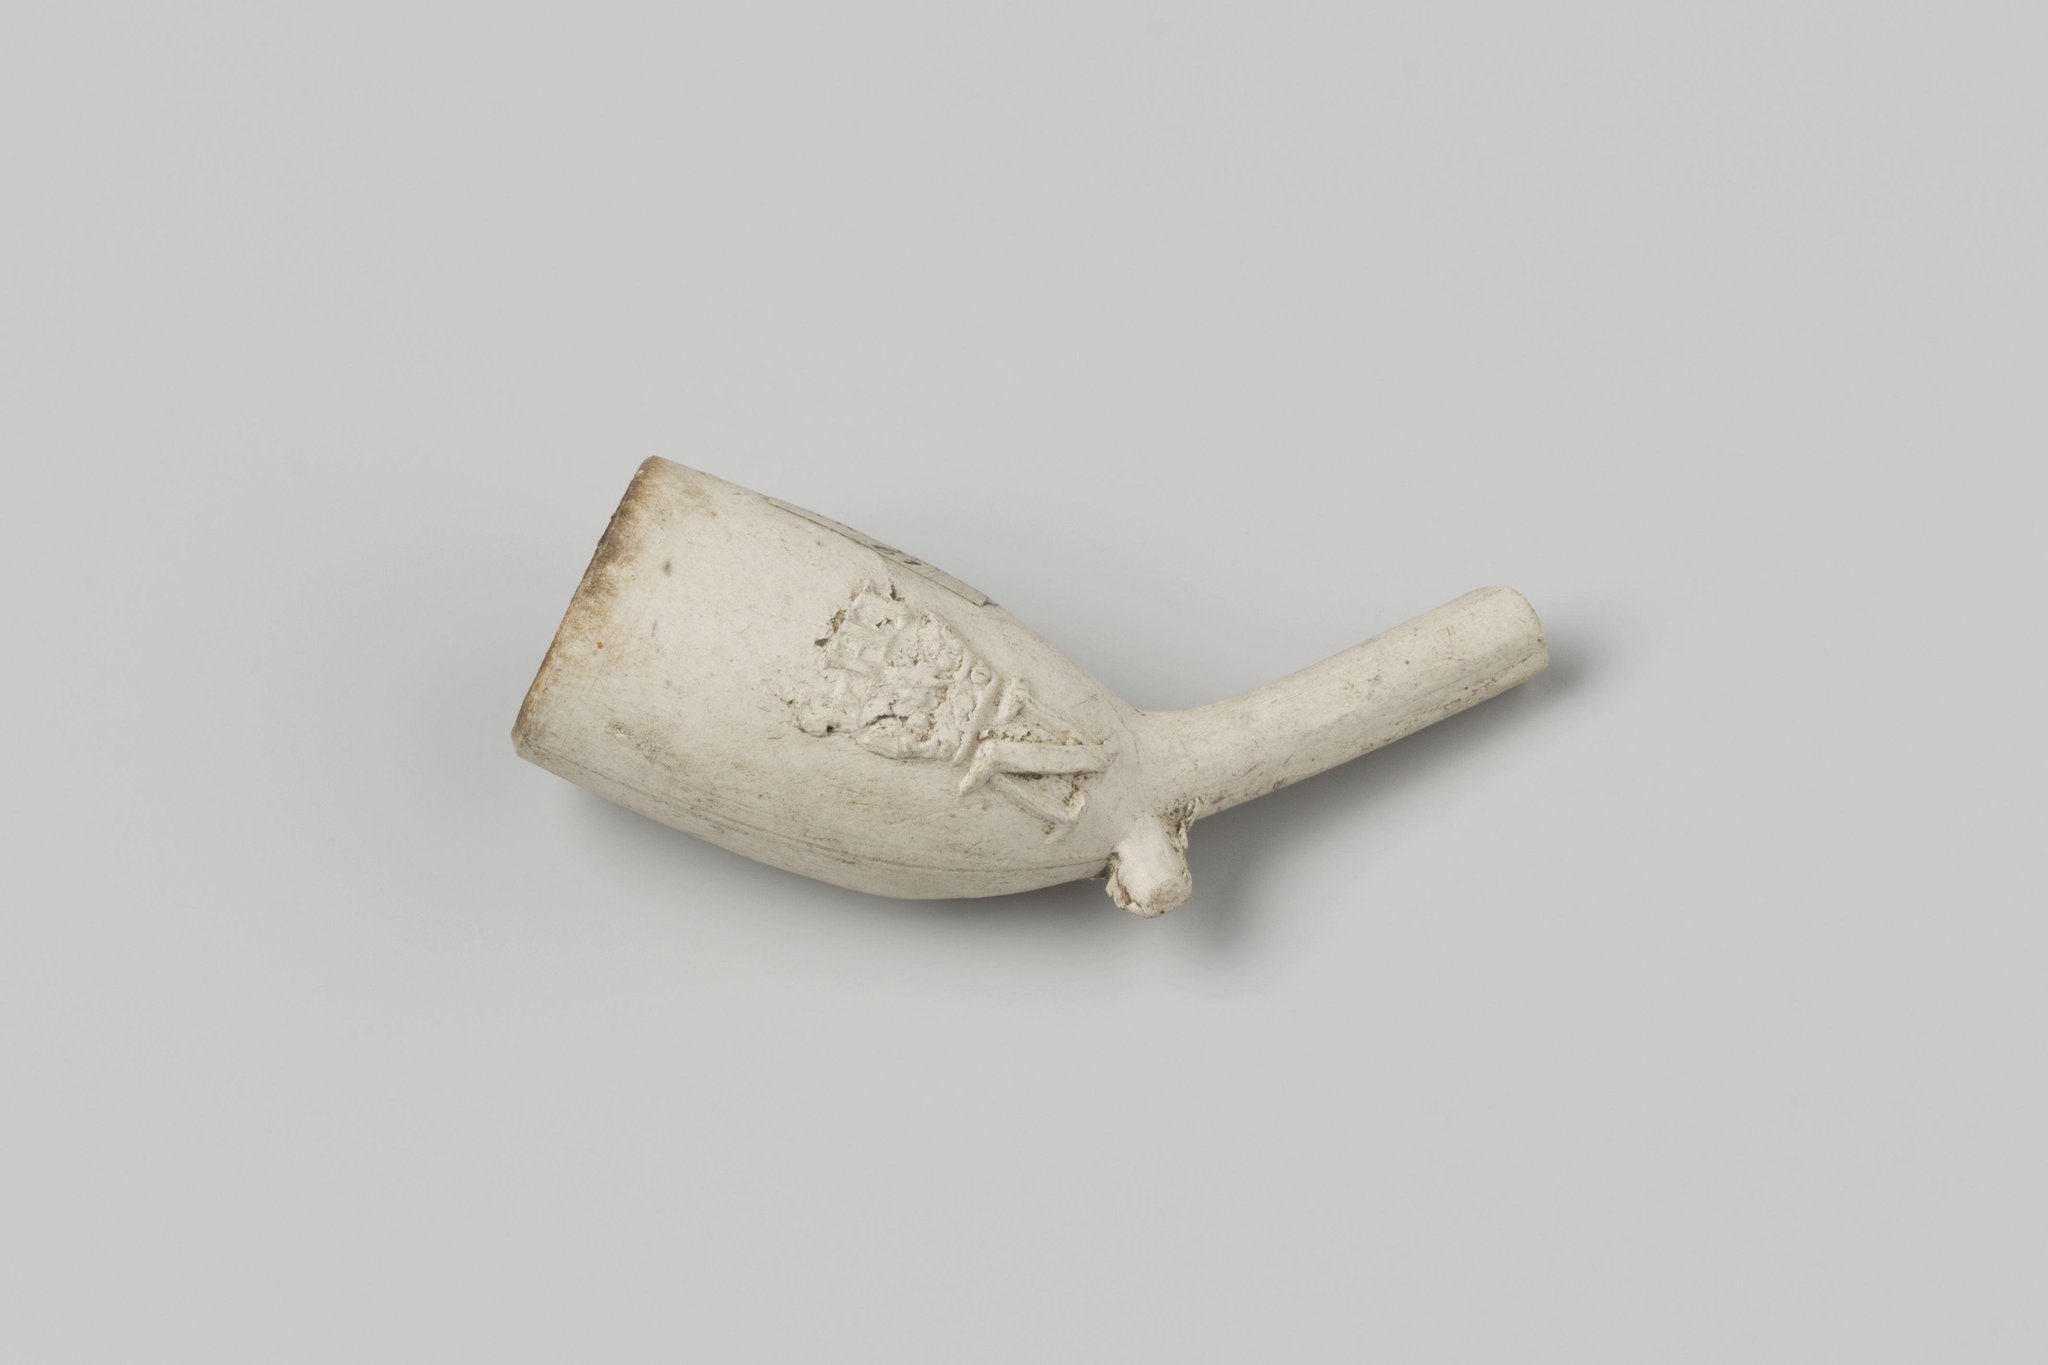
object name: pipe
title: Fragment tabakspijp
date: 1750-1790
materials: clay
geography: schoonhoven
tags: directeur, hoogleraar, caspar jacob christiaan reuvens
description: Fragment tabakspijp met een kroon en de letters G H L en N afgebeeld. Van de opgravingen op de Hofstede Arentsburg 1827-1831 onder toezicht van Professor Reuvens.